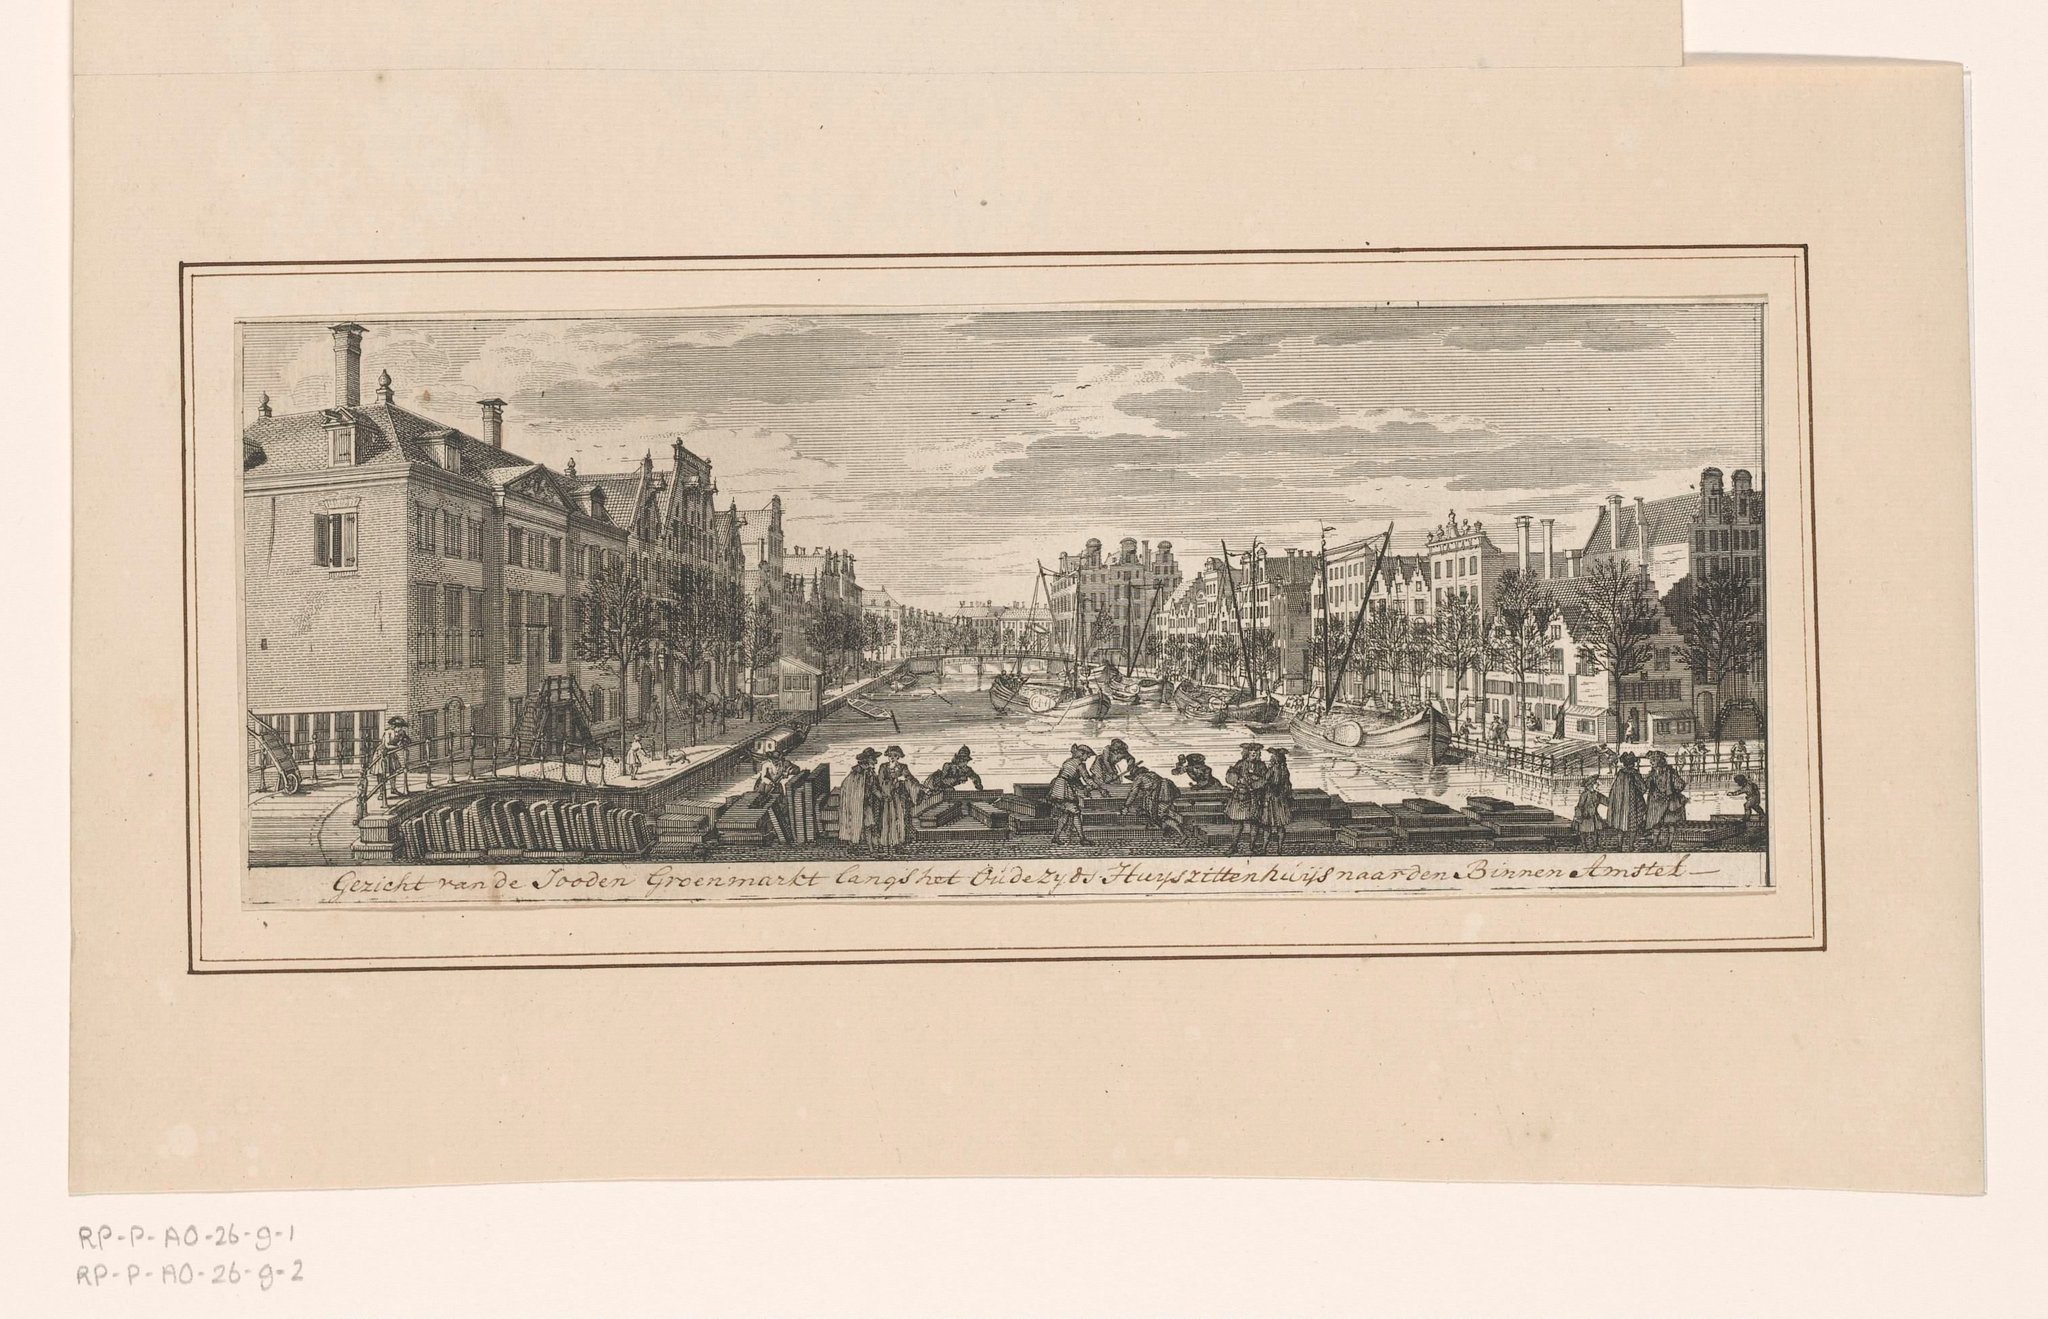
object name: print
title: Gezicht van de Jooden Groenmarkt langs het Oudezyds Huyszittenhuijs naar den Binnen Amstel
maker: adolf van der laan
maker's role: draughtsman, print maker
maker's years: 1689-1742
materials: ink, paper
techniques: etching, pen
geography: amsterdam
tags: bridge in city across river, canal, etc. (+ city(-scape) with figures, staffage), public welfare, poorhouse, canals, waters (in city) (+ city(-scape) with figures, staffage), street (+ city(-scape) with figures, staffage)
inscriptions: collector's mark: Lugt 195, inscription: ‘Gezicht van de Jooden Groenmarkt langs het Oudezyds Huyszittenhuijs naar den Binnen Amstel’, collector's mark: Lugt 2228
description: Afgesneden van een proefdruk van één van de twee platen van de prent 'Platte gronden van het Oude Zyds Huiszitten Huis en Huiszitten Weduwen Hof, beneven deszelfs opstallen'. Deze prent bestaat uit plattegronden van het Oudezijds Huiszittenhuis en het Huiszitten Weduwenhof (Kartuizerhof), met daaromheen allegorische voorstellingen, wapenschilden en gezichten op verschillende delen van beide gebouwen. Huidige object is afgesneden van een poefdruk van de linkerplaat. Zie ook RP-P-AO-26-9-1, RP-P-AO-26-10, RP-P-AO-26-11-1, RP-P-AO-26-11-2, RP-P-AO-26-17 en RP-P-AO-26-18.